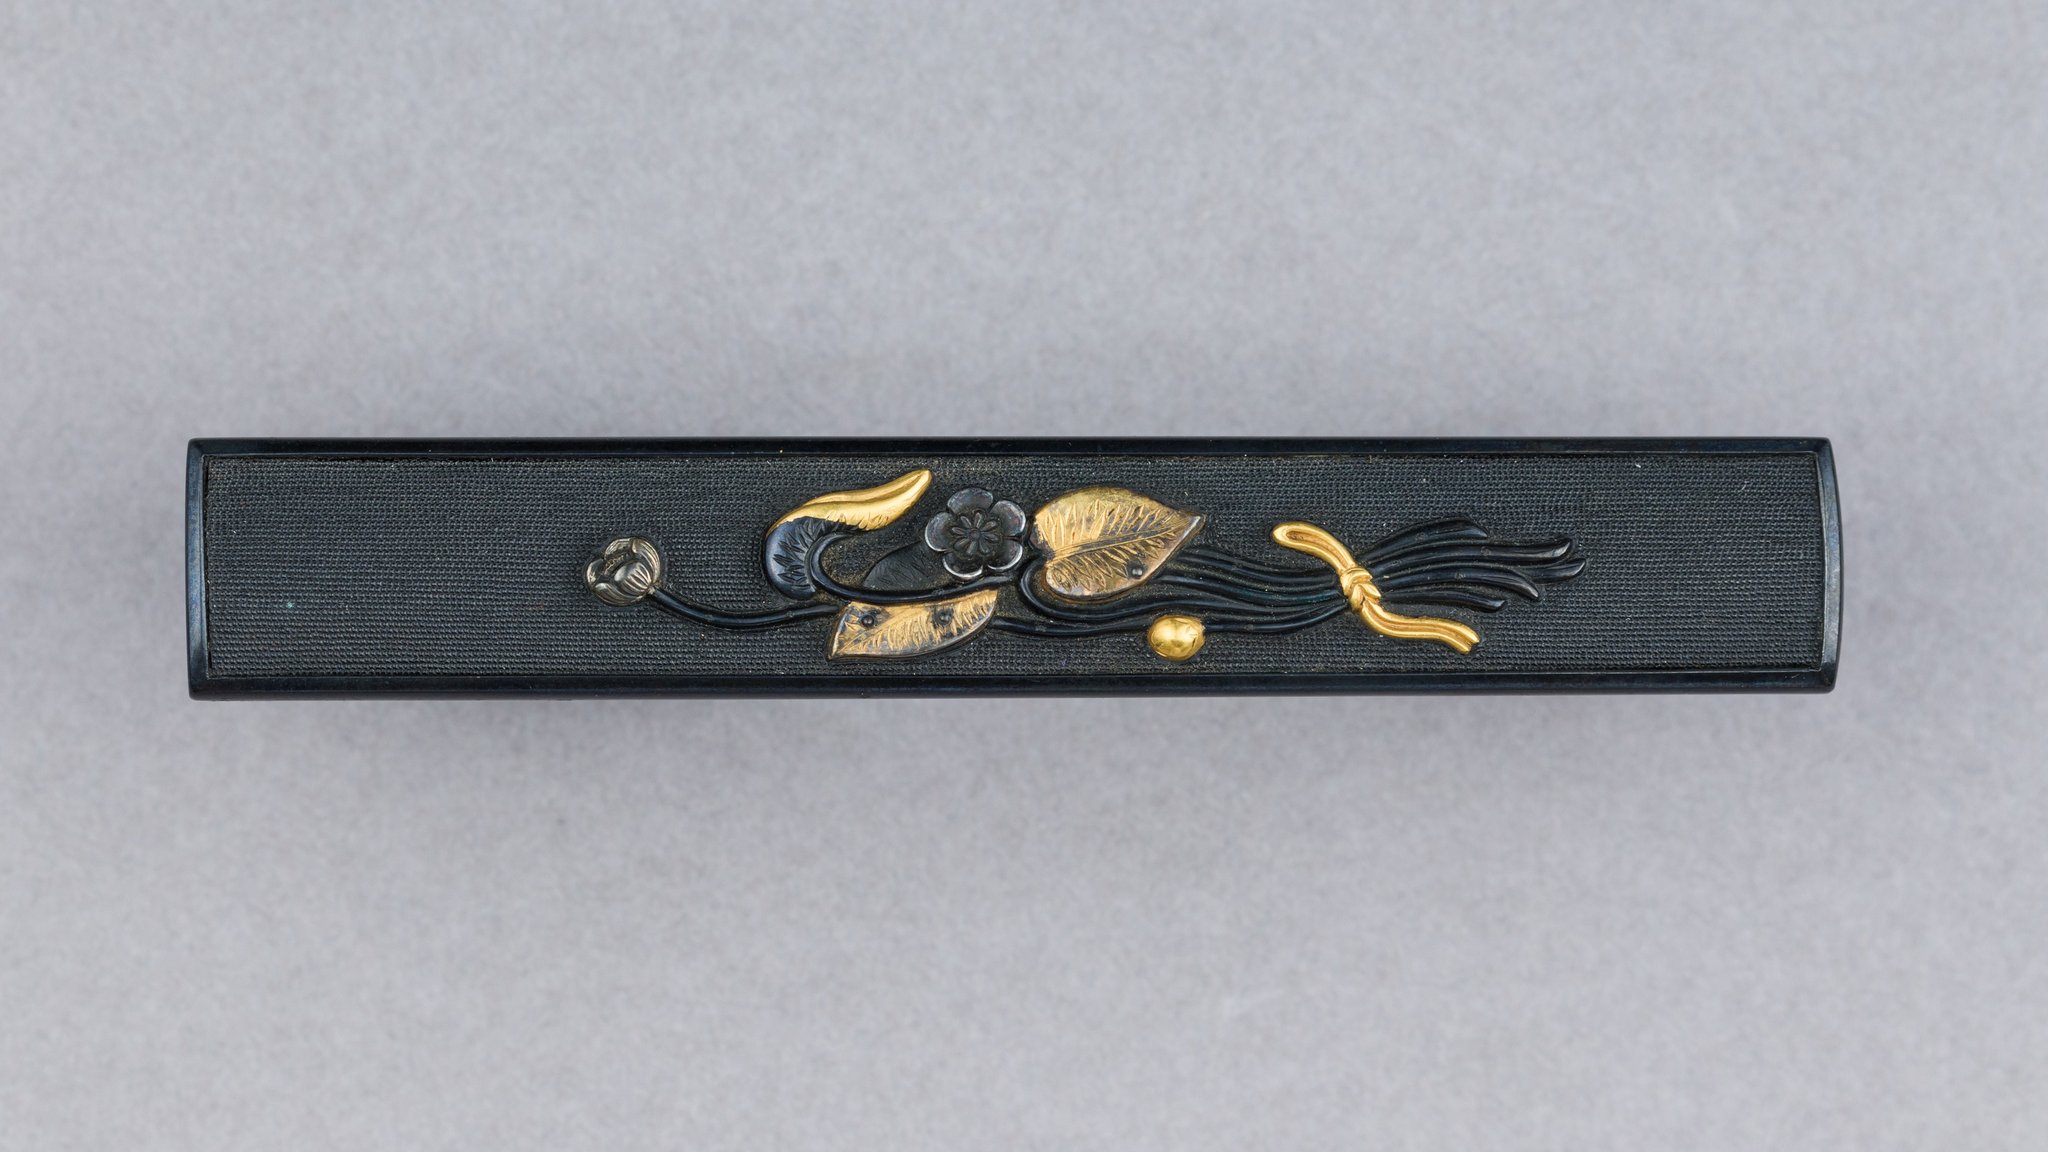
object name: knife handle kozuka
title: Knife Handle (Kozuka)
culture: japanese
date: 1801-1900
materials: gold alloy, gold, silver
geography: japan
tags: flowers